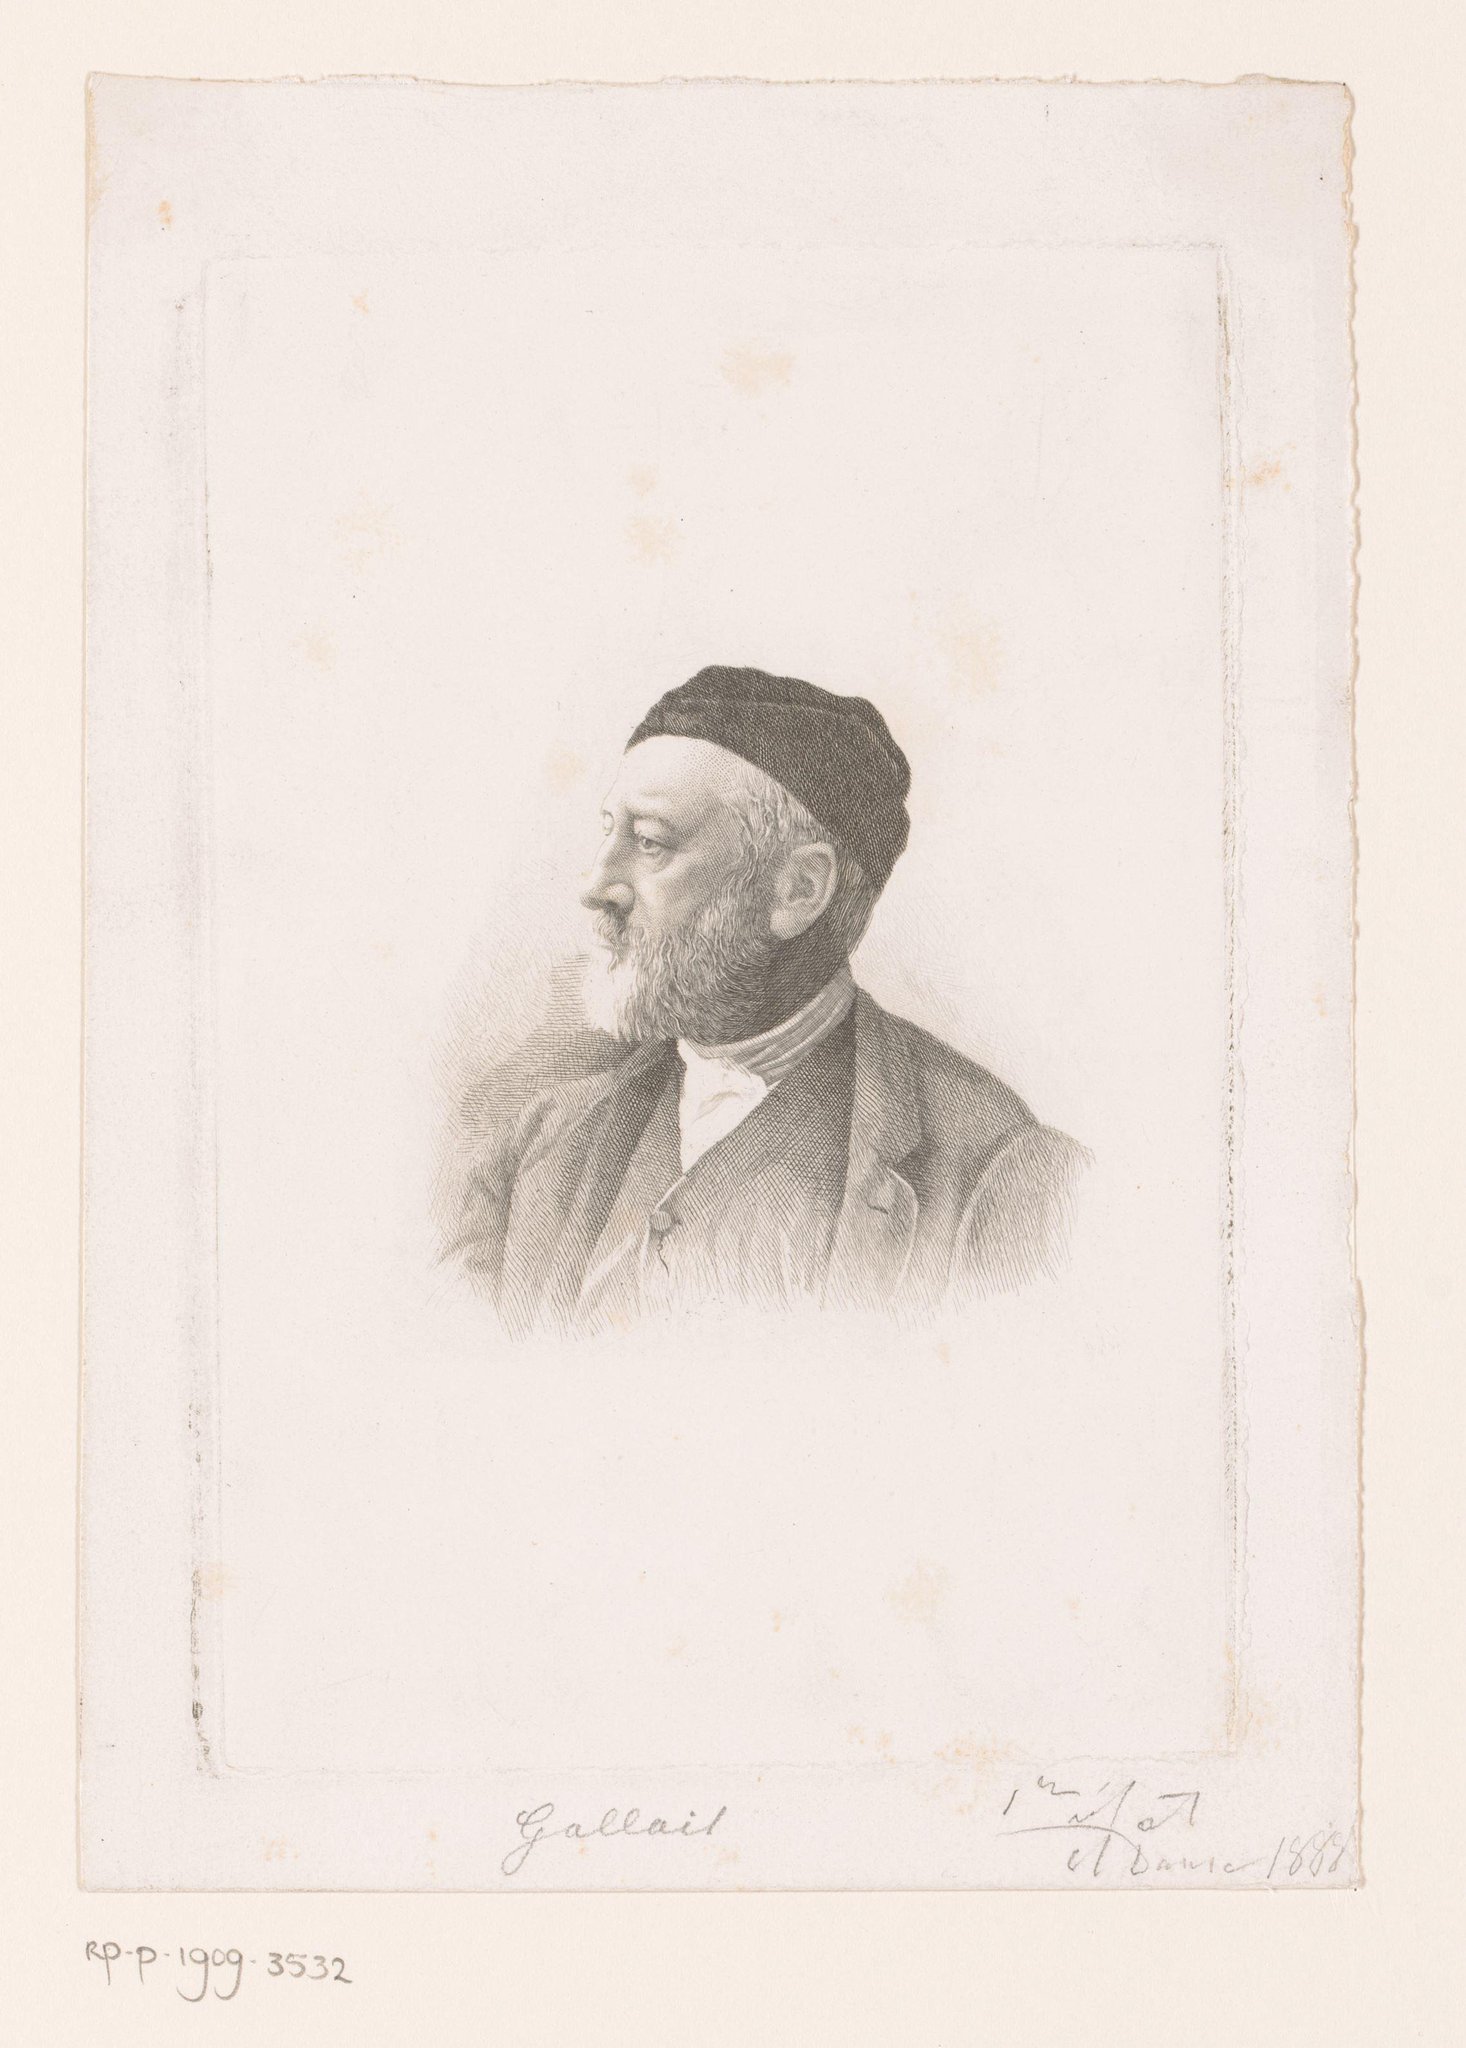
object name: print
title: Portret van Louis Gallait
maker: auguste danse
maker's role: print maker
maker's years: 1829-1929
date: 1888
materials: paper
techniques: etching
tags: painter, print maker, draughtsman, louis gallait, portrait, self-portrait of painter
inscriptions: collector's mark: Lugt 2228, annotation: ‘1er état’